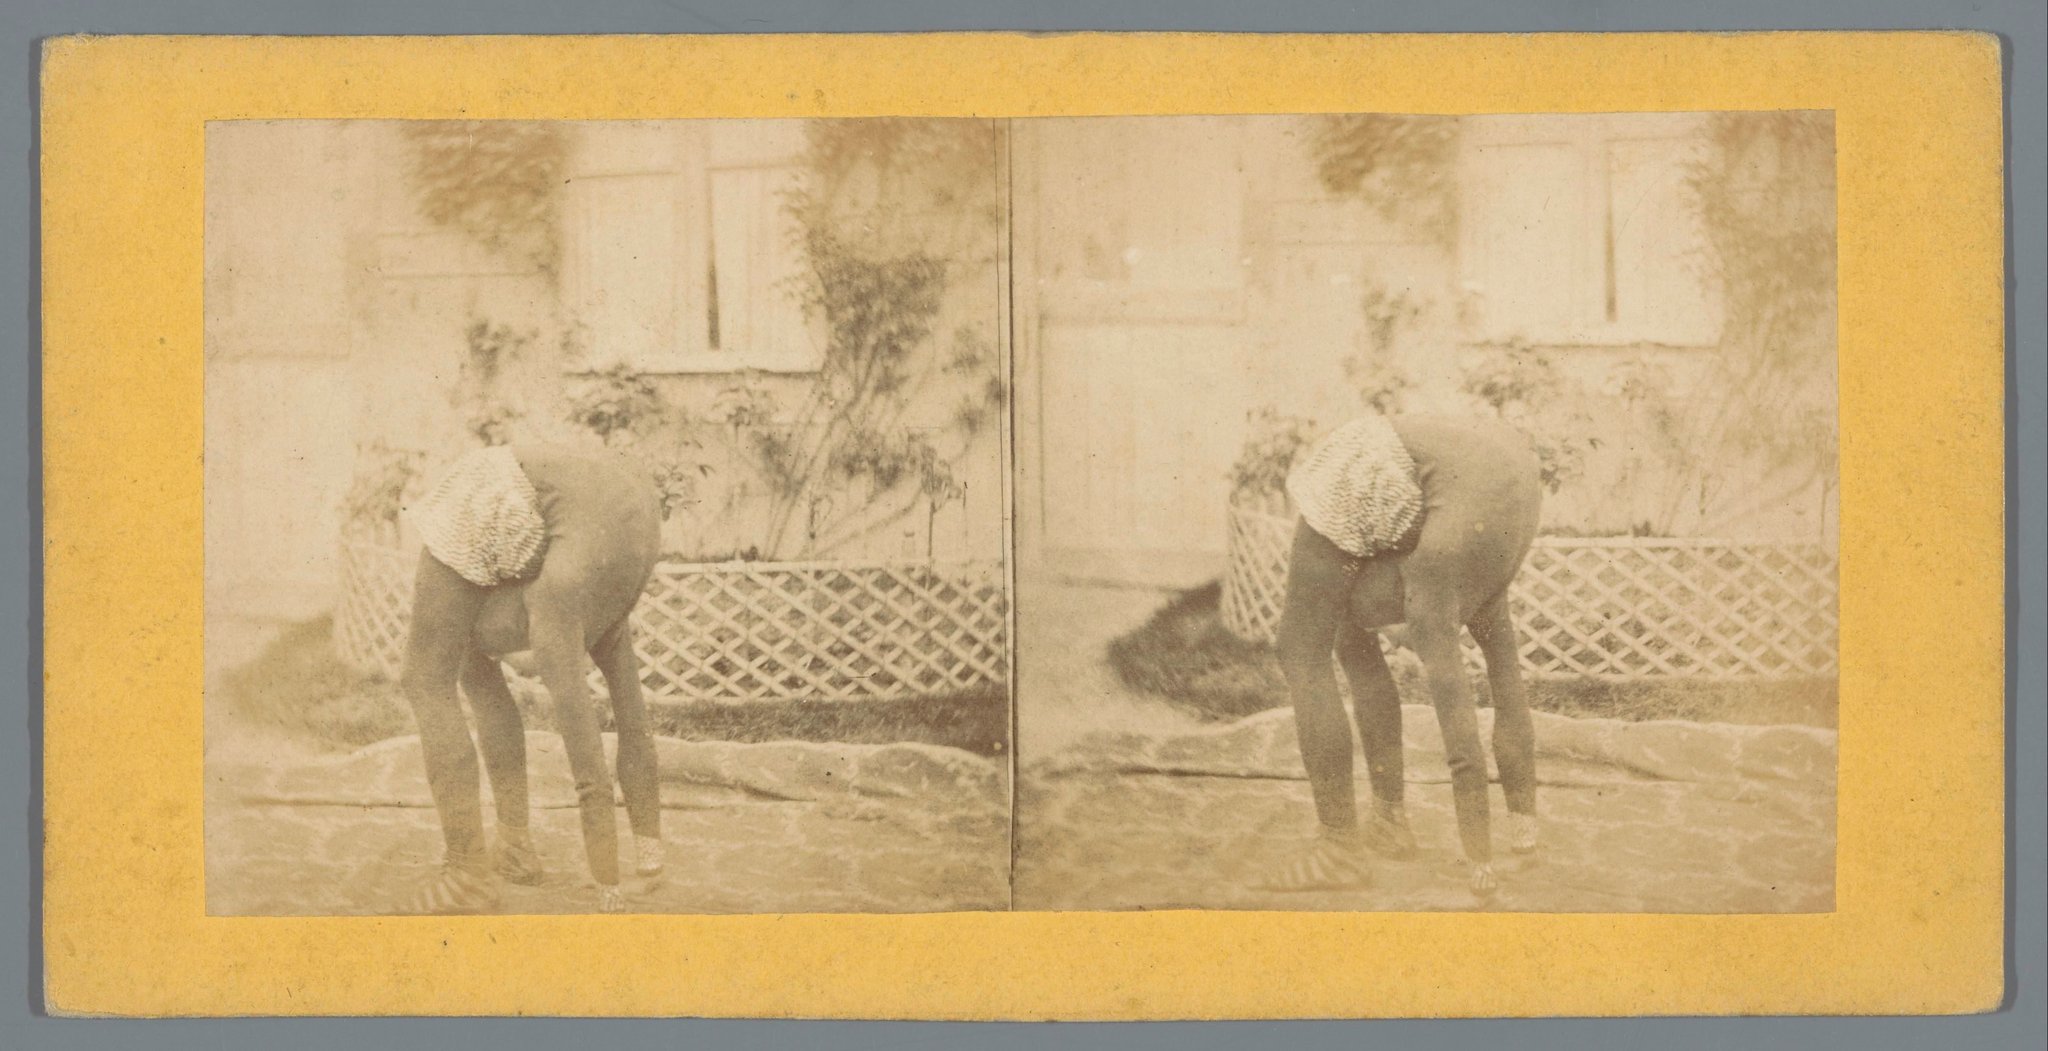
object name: stereograph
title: Acrobaat in een tuin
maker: Anonymous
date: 1850-1880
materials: cardboard, photographic support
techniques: albumen print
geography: europe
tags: acrobat ~ circus, europe